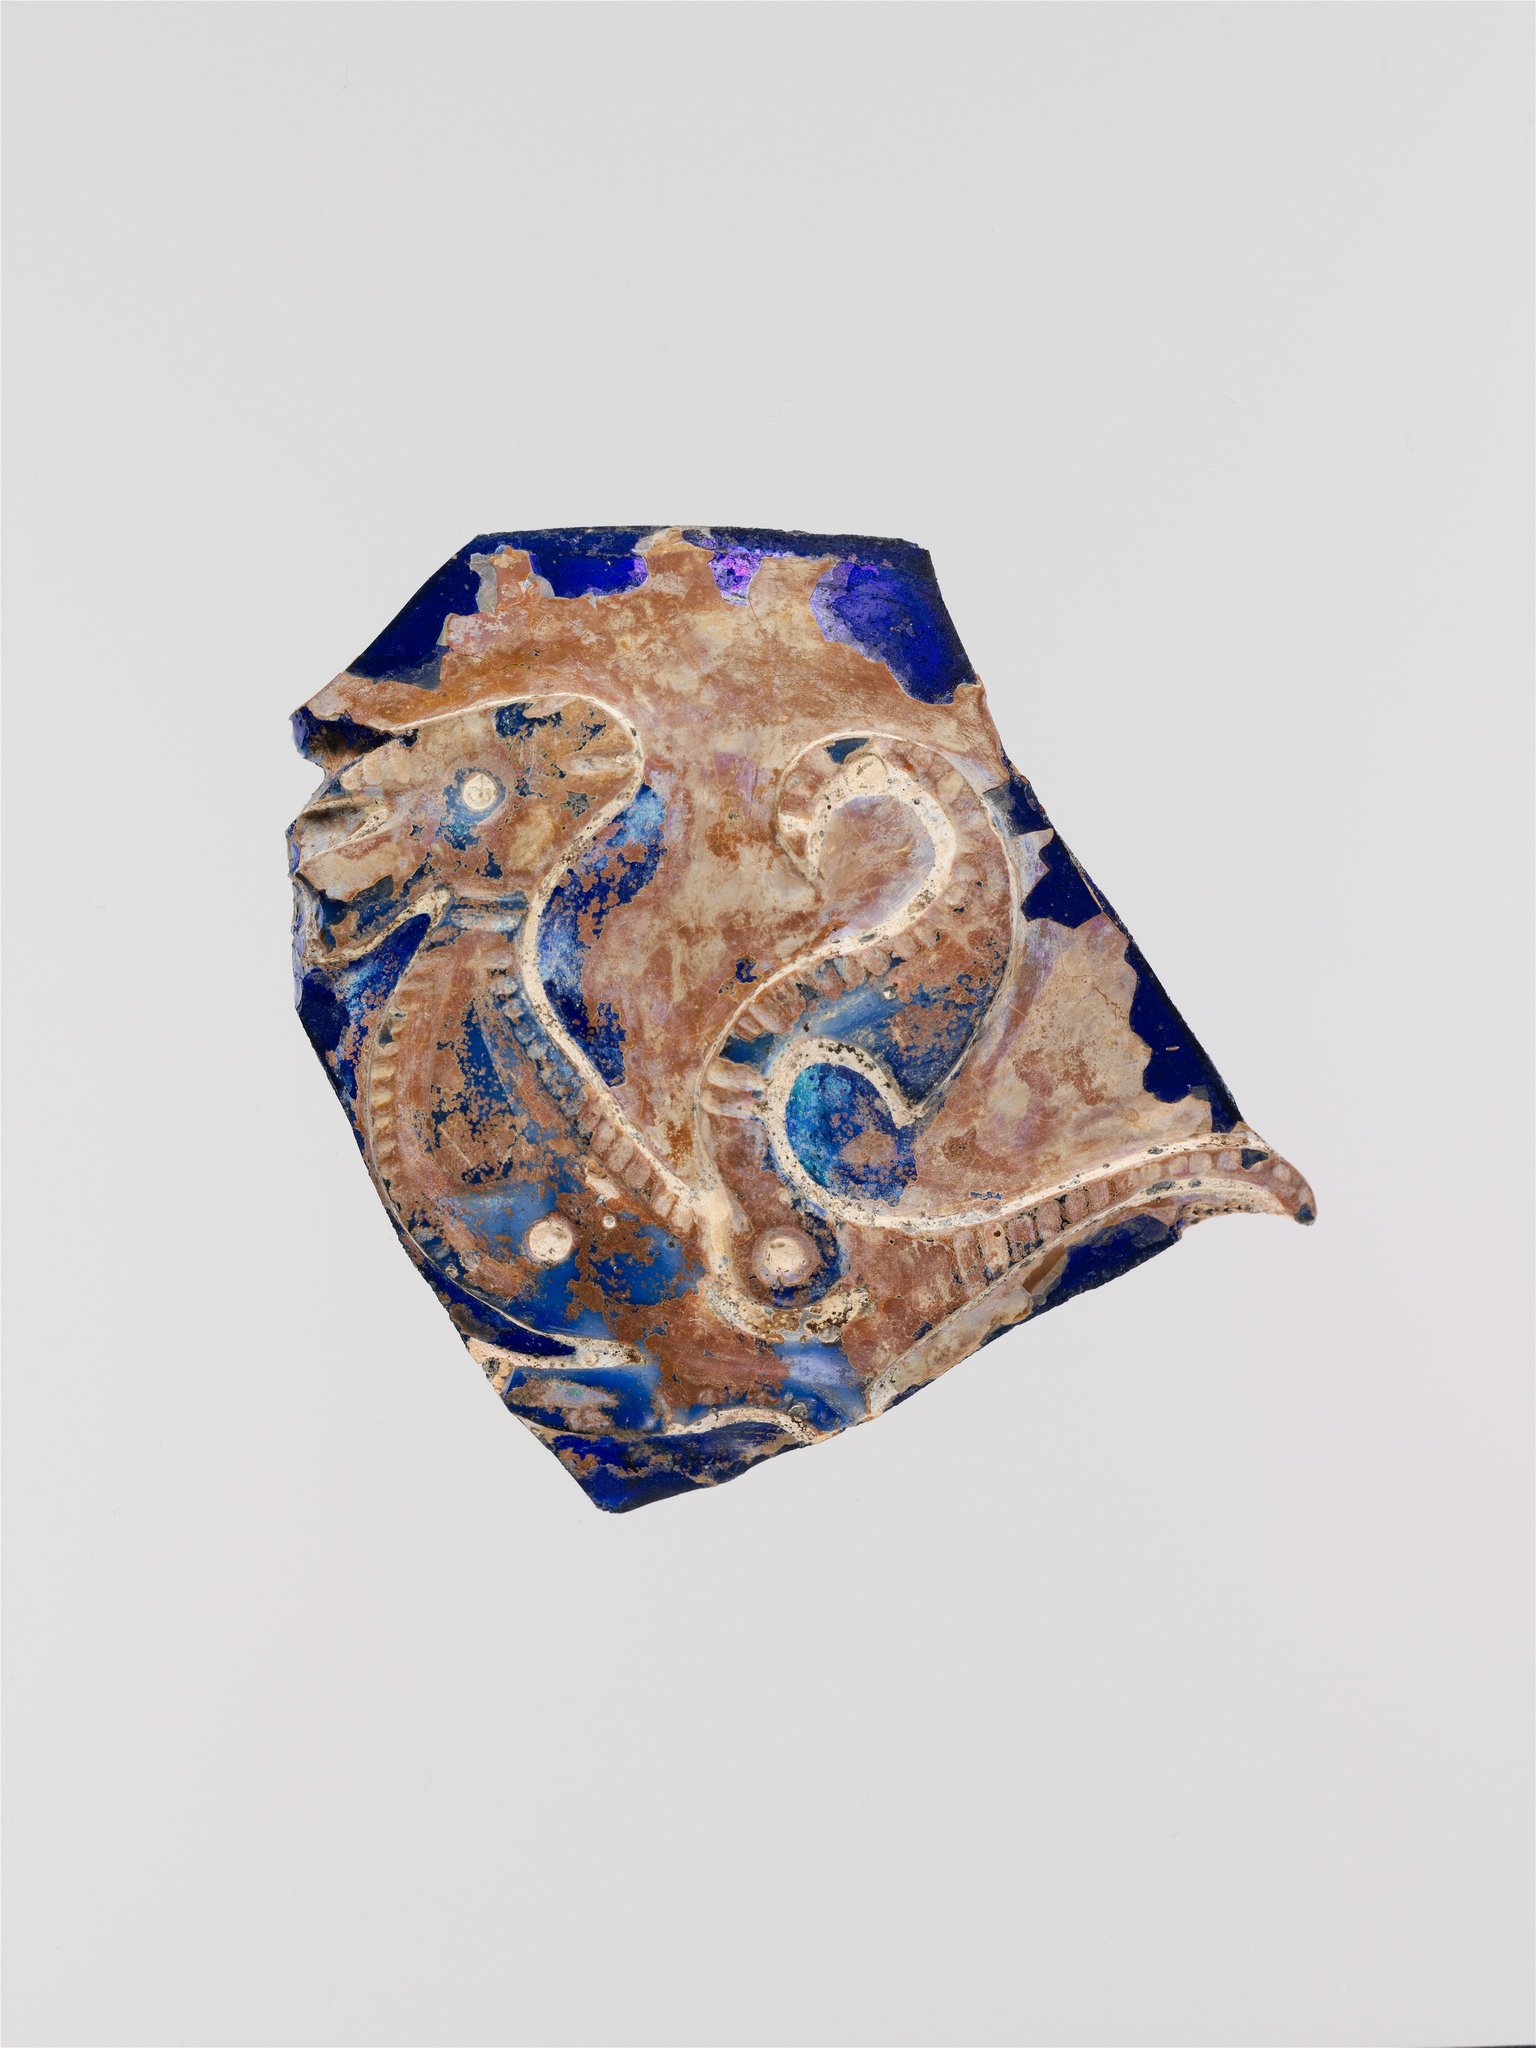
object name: fragment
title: Glass Fragment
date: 801-900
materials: glass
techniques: glassblowing, cutting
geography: iran